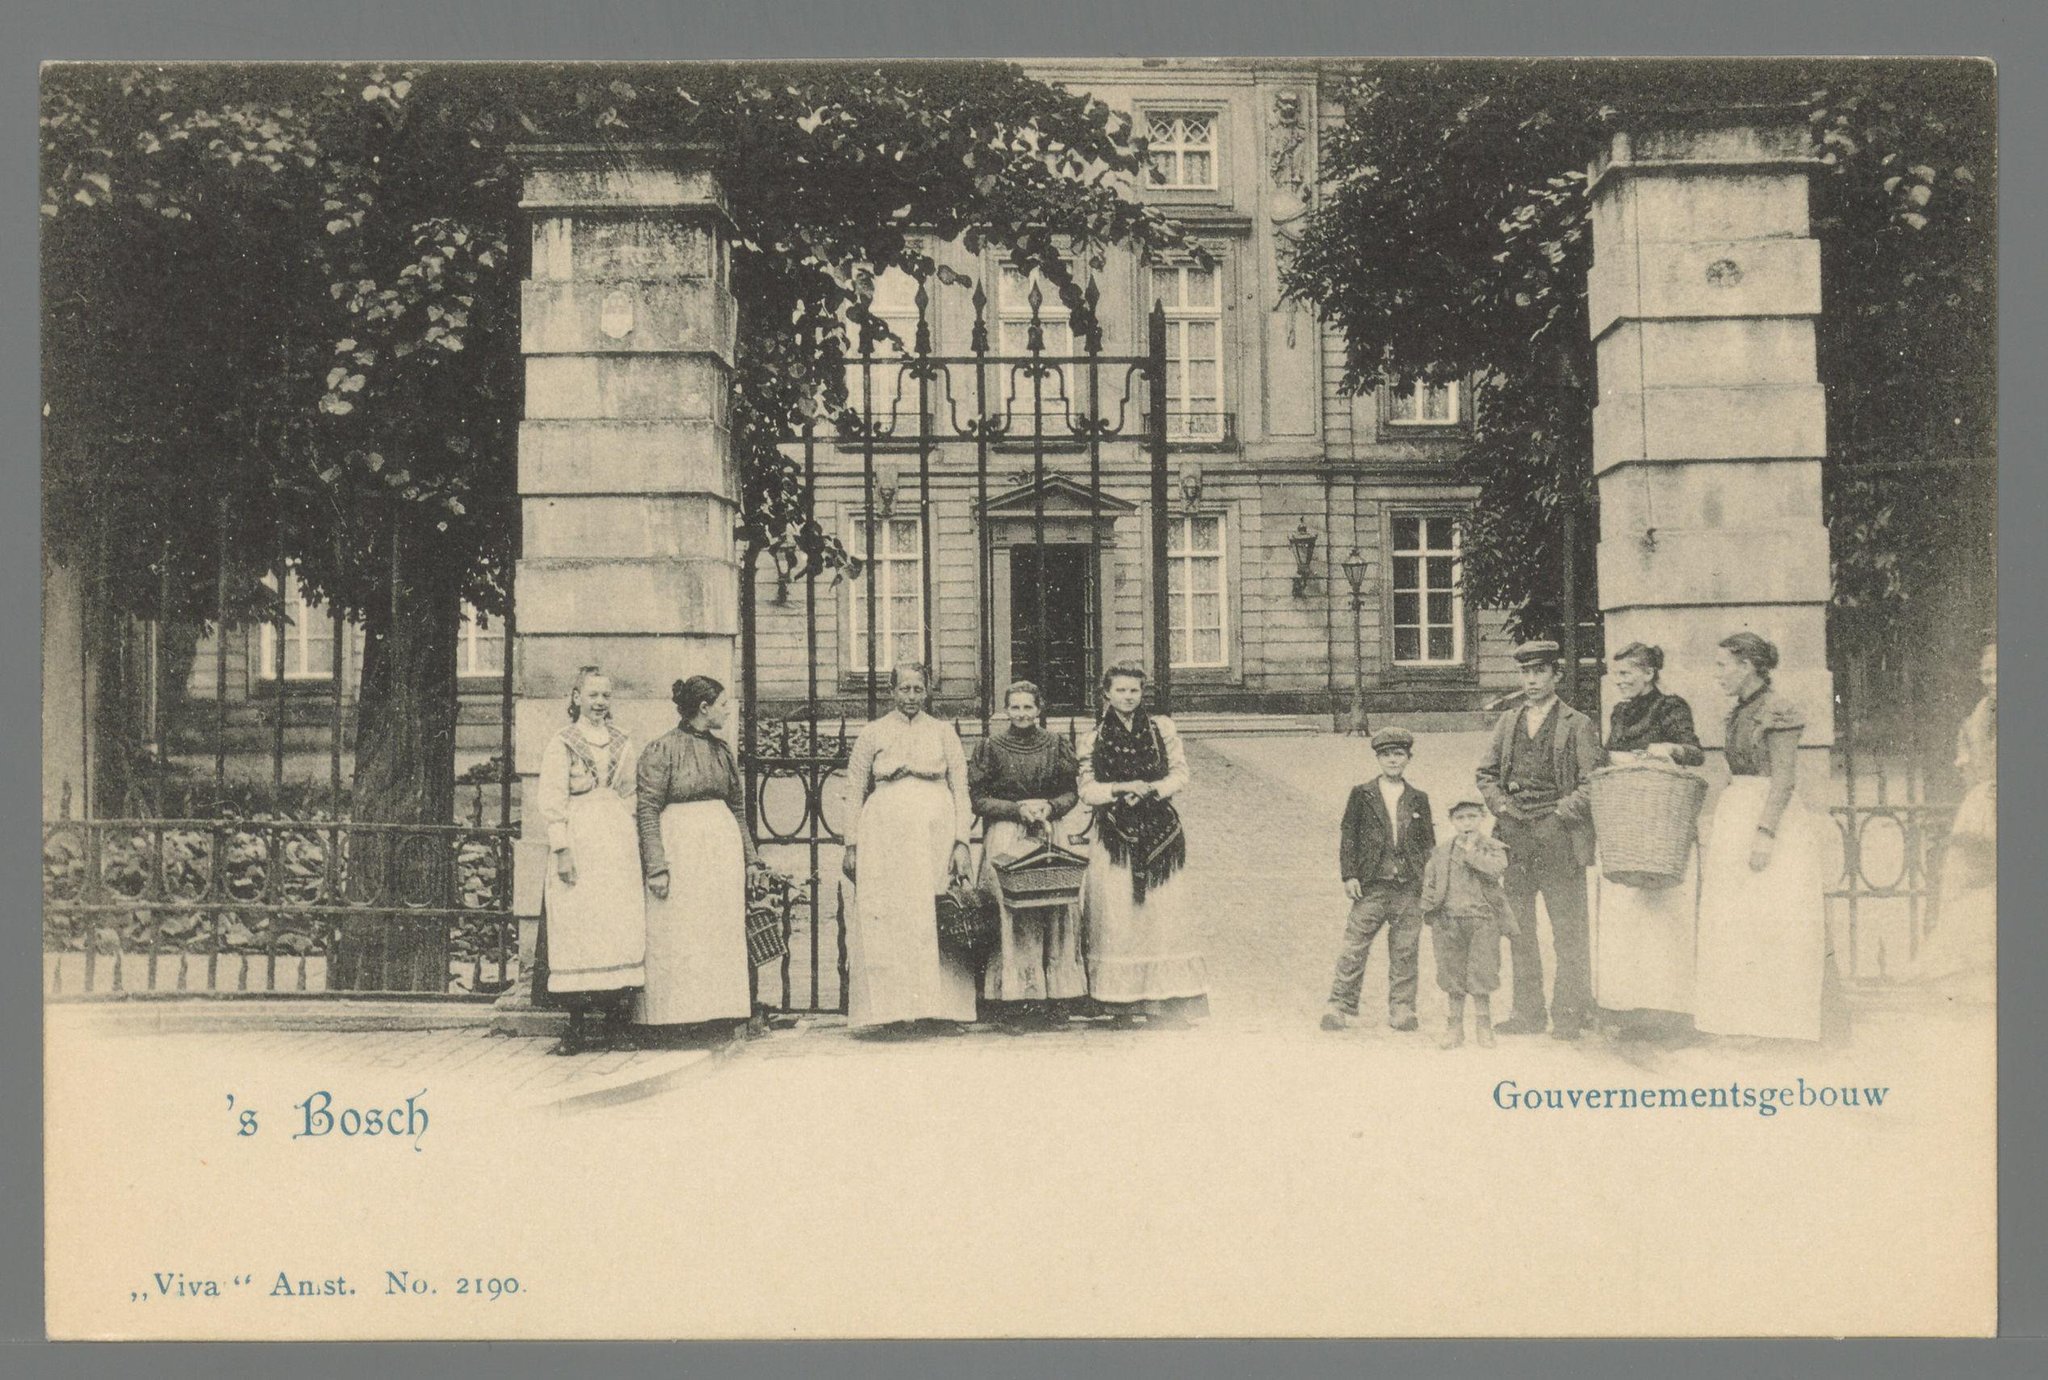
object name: photomechanical print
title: 's Bosch. Gouvernementsgebouw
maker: Anonymous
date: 1897-1905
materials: cardboard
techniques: photograph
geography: amsterdam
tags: gate, entrance, den bosch